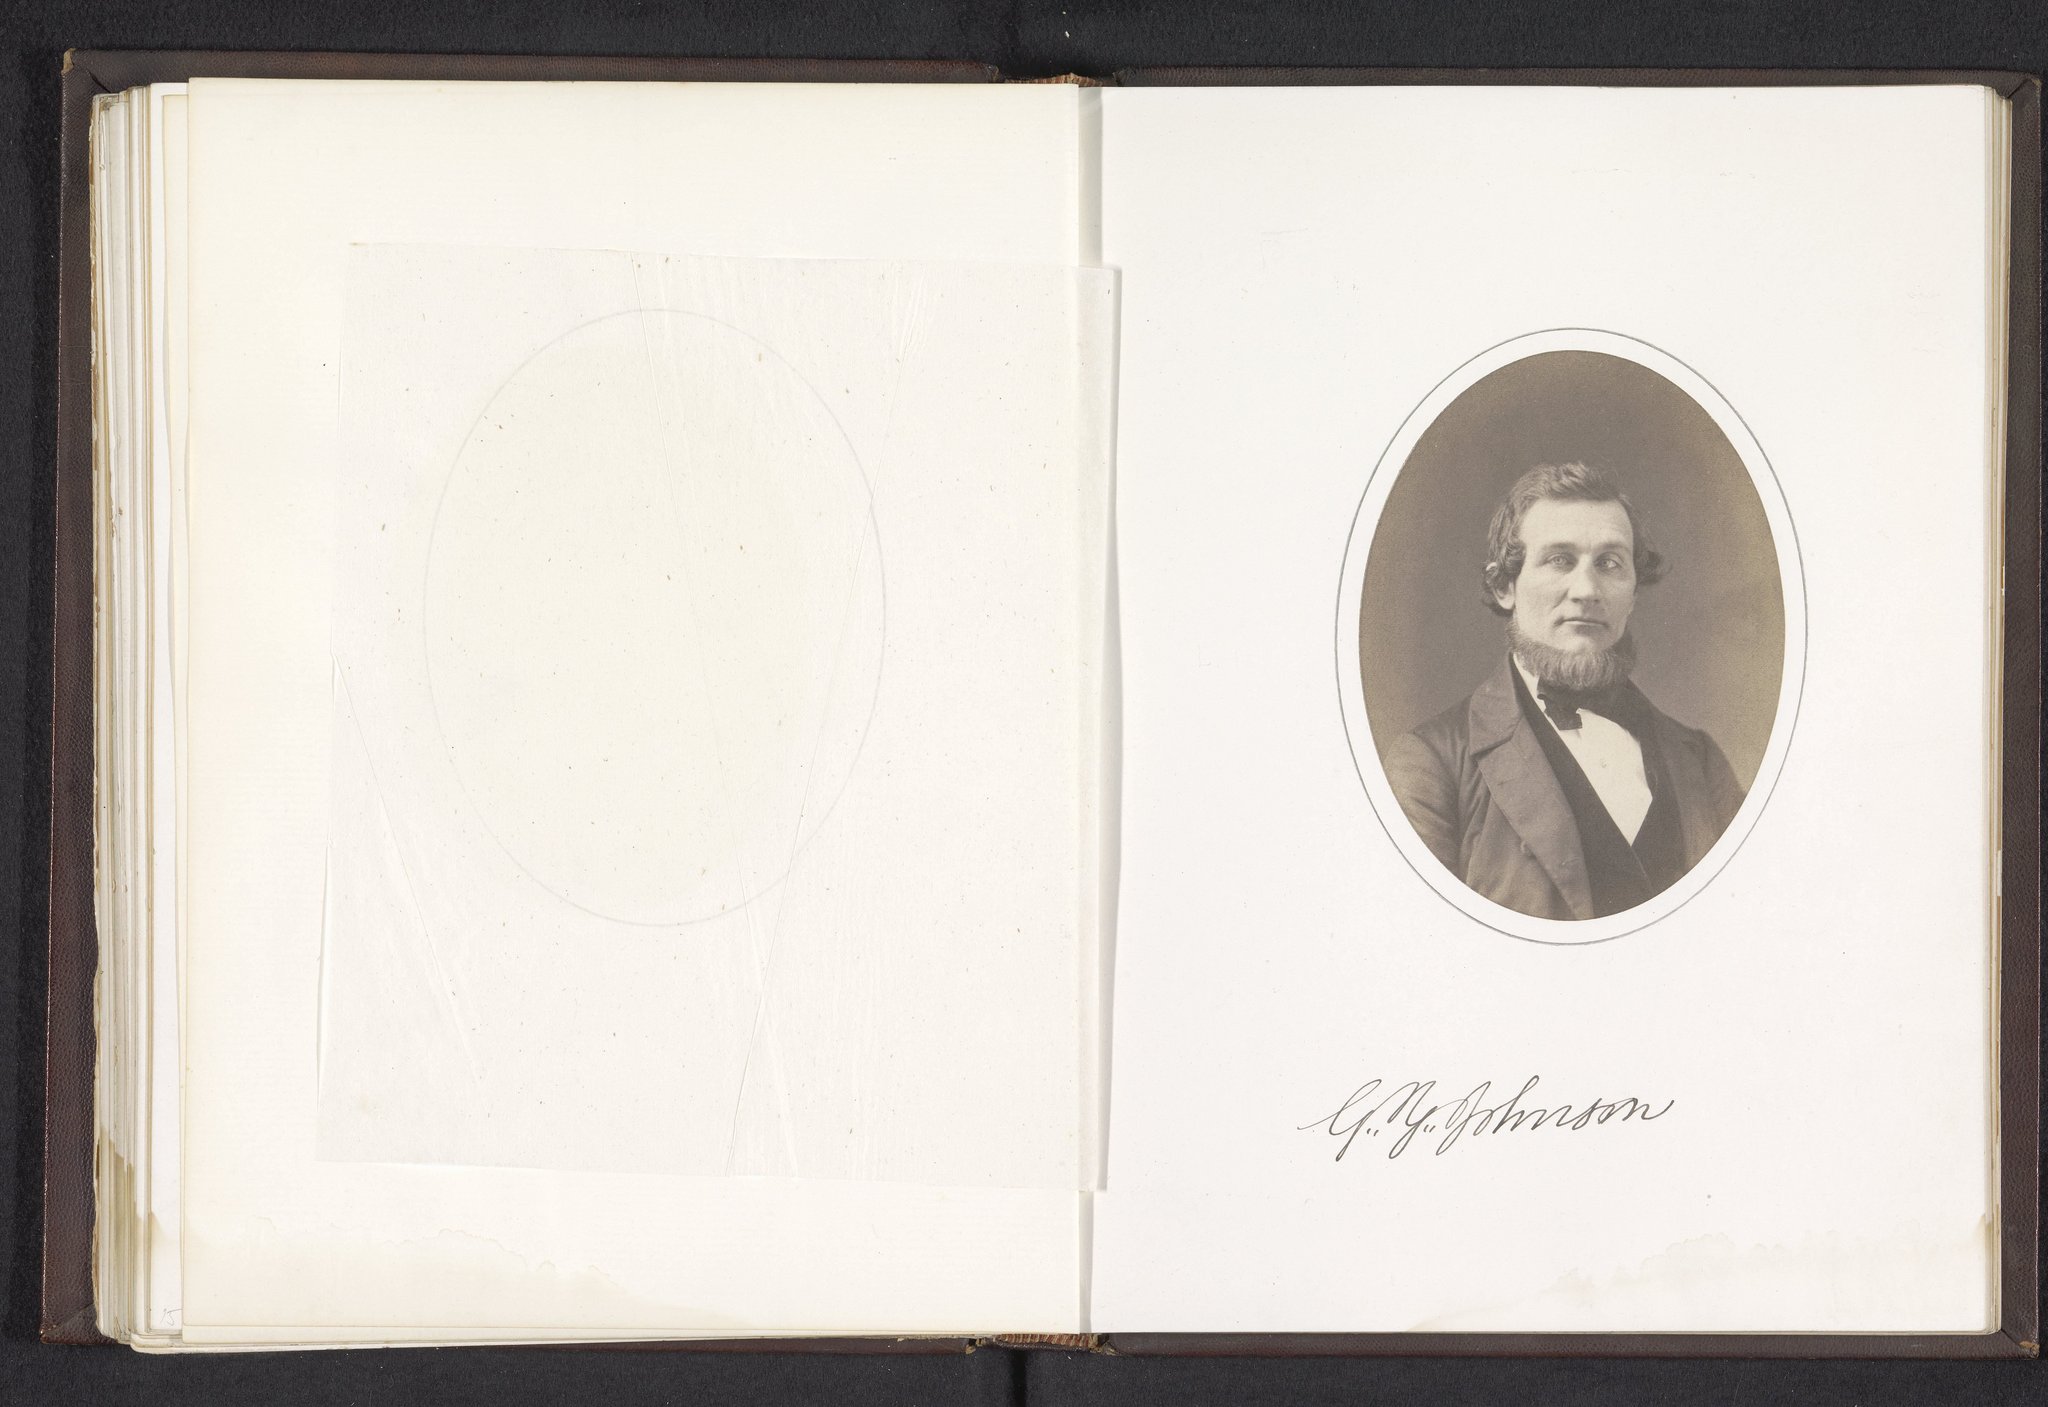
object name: photograph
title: Portret van Senaatslid John D. Willard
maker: d.t.t. davie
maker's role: publisher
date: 1858-1859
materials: photographic support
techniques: salted paper print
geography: new york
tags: politician, politician, e.g. party leader, upper house, senate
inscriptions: inscription: ‘John D. Willard’